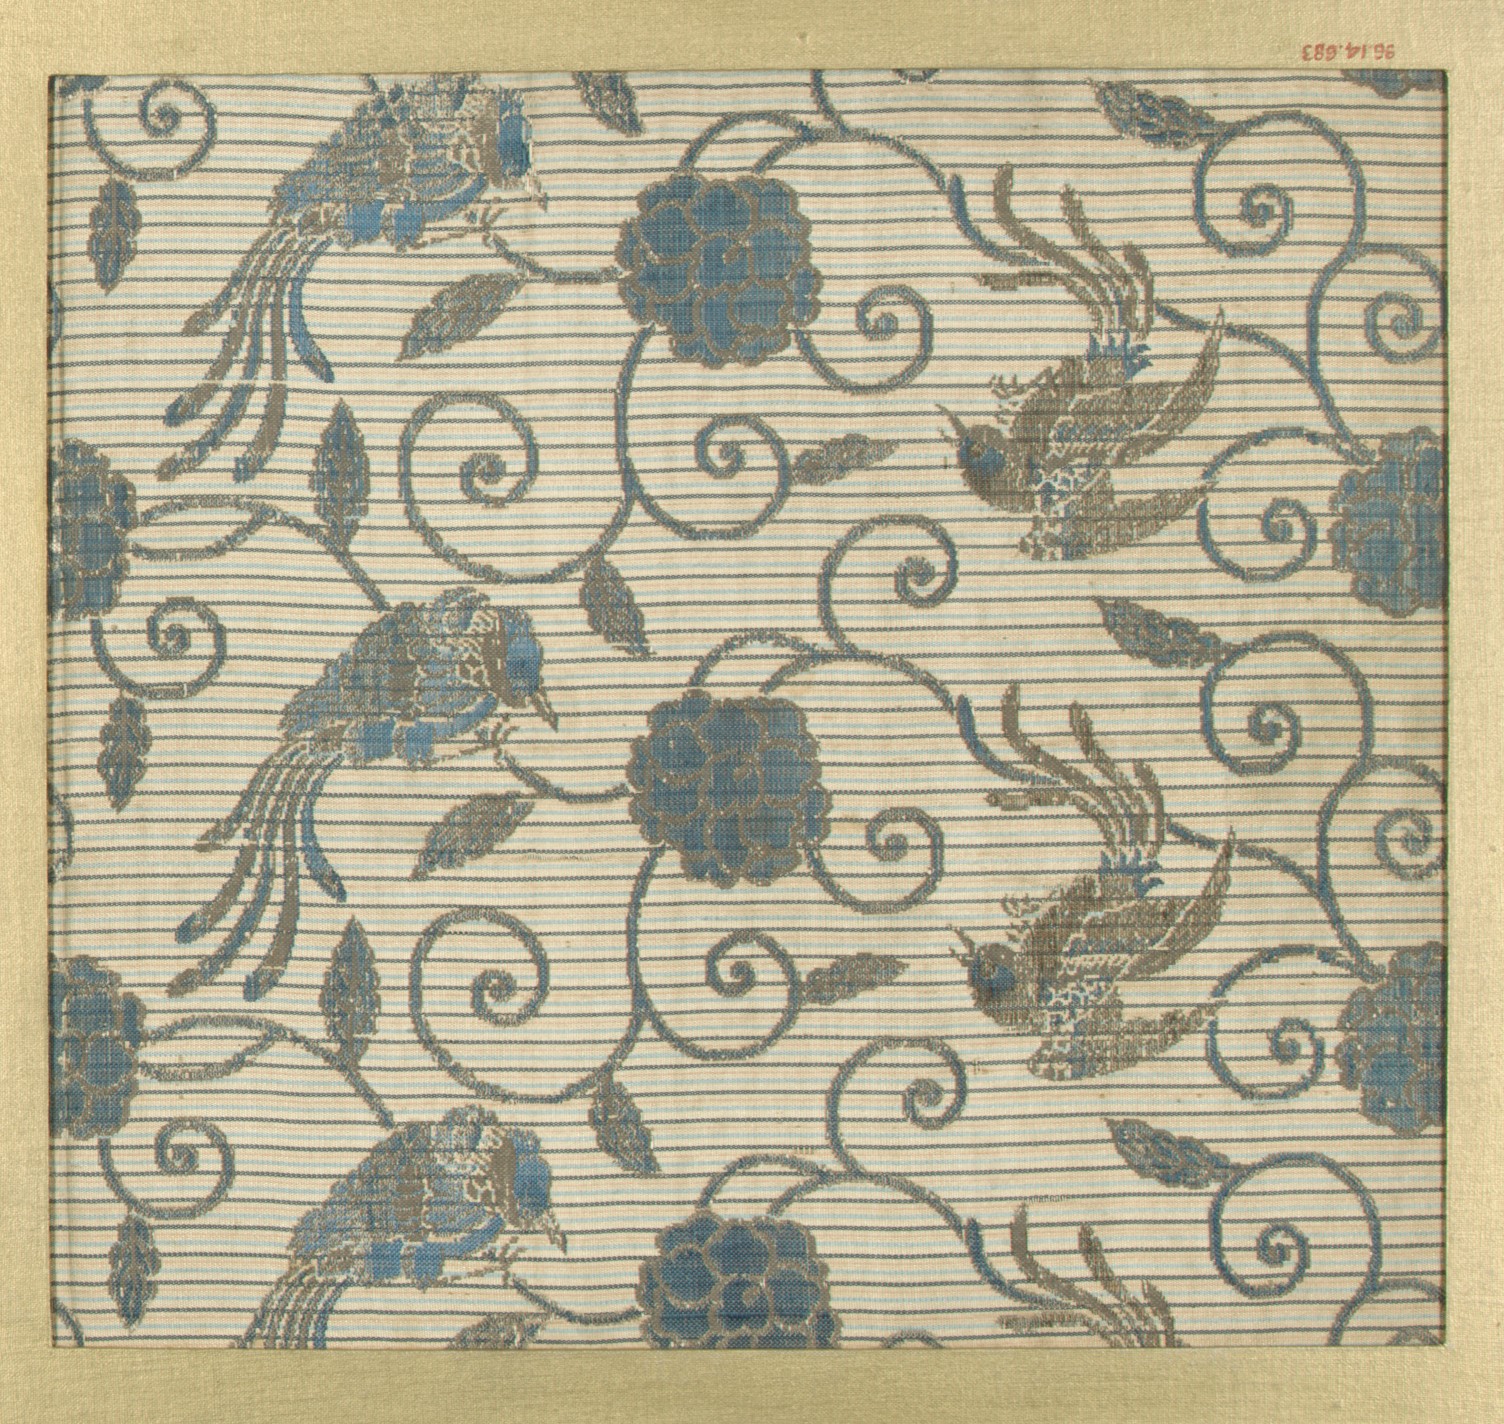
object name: piece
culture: japanese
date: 1701-1900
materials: silk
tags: flowers